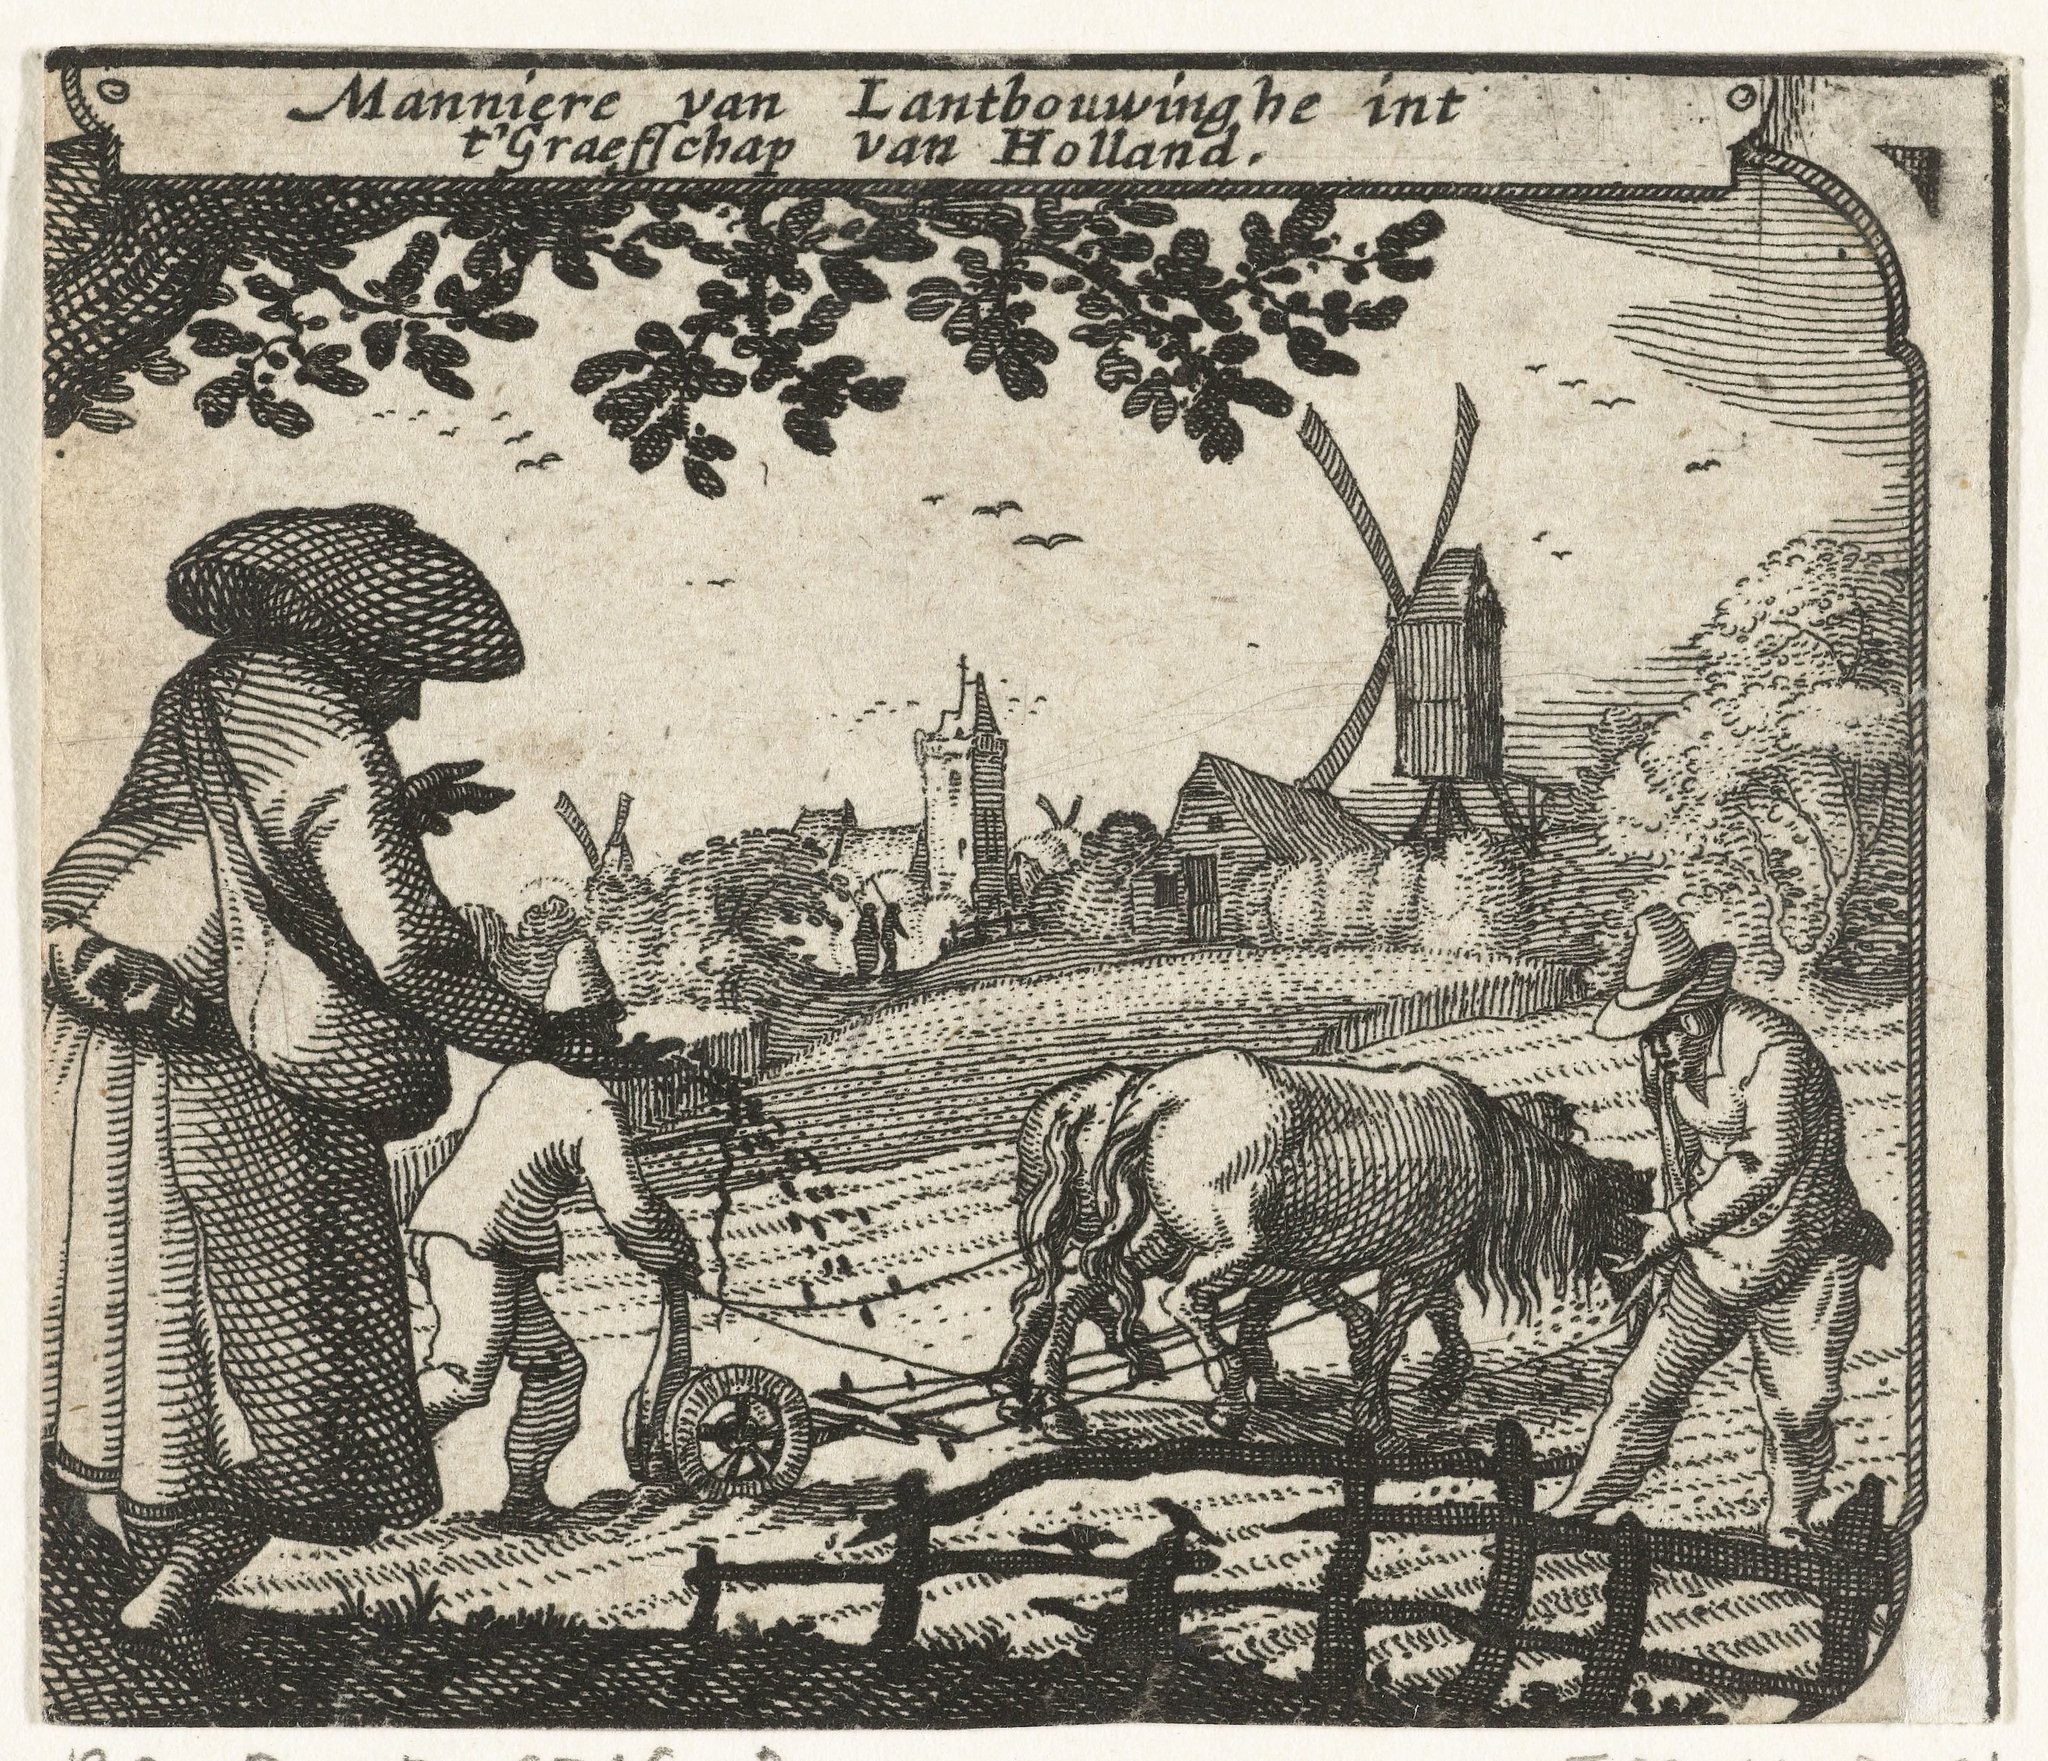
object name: print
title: Illustraties uit het randwerk bij de kaart van Holland van 1610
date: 1608-1610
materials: paper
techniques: etching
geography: northern netherlands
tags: agriculture, holland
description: Kostuums, bedrijvigheden en legendes in Holland, illustraties bij kaart van Holland. De landbouw in Holland, zaaien en ploegen, ca. 1600. Boven de plaat een of twee regels beschrijving.